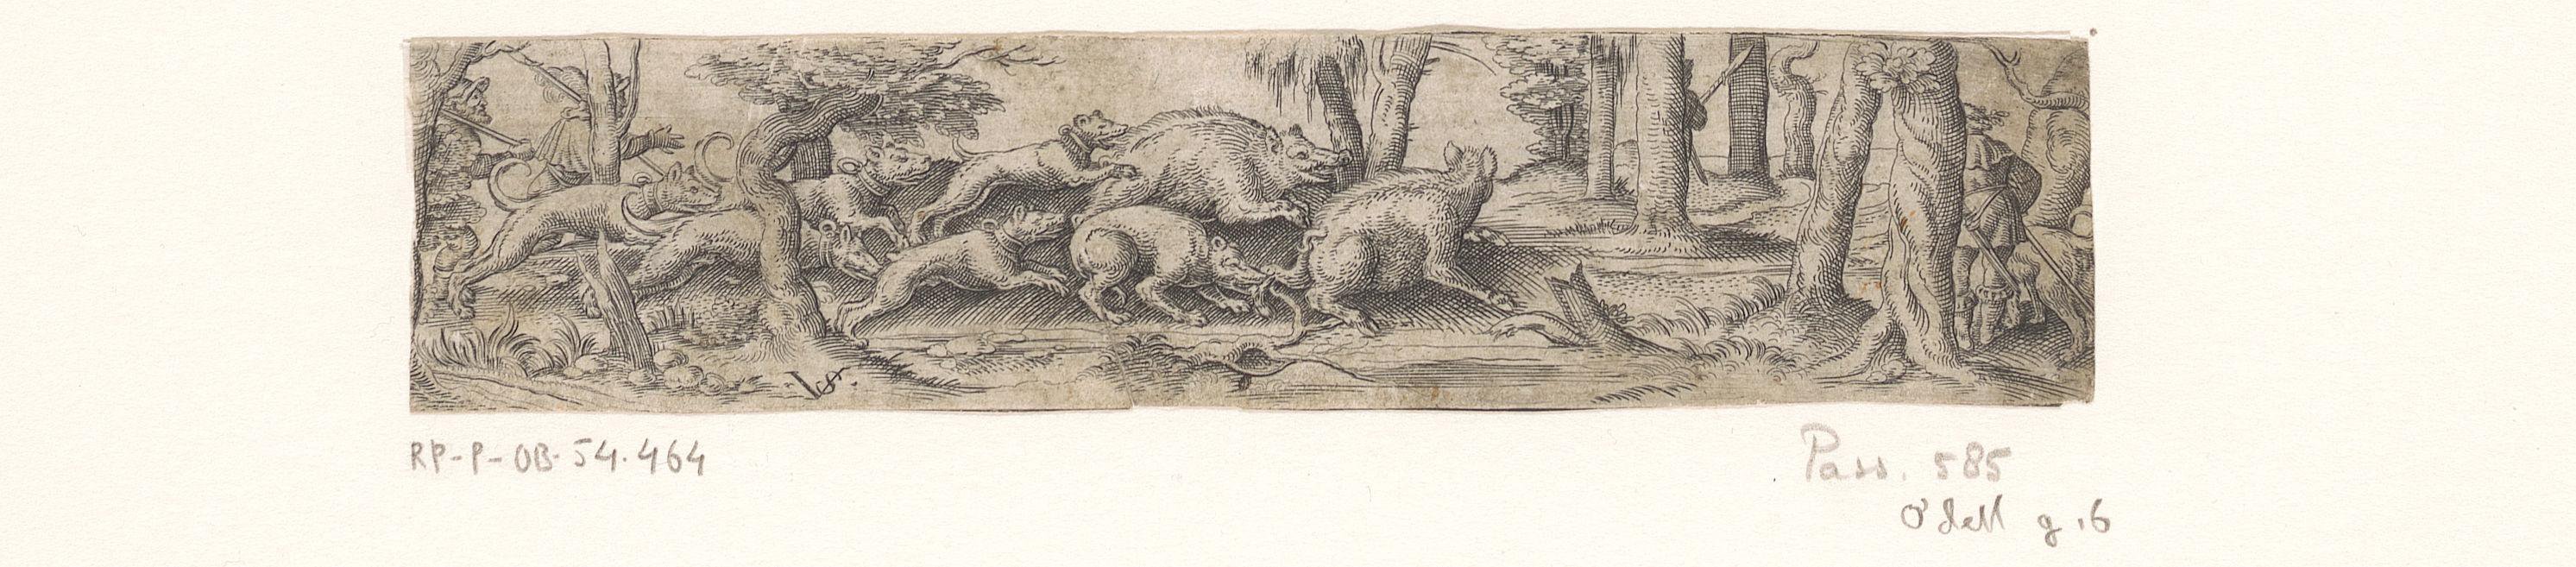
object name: print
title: Wilde zwijnenjacht met twee omcirkelde zwijnen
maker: virgilius solis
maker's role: draughtsman, print maker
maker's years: 1514-1562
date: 1524-1562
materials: paper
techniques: engraving, intaglio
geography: nuremberg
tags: hunting dogs, boar-hunting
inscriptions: number: ‘30’, collector's mark: Lugt 2228